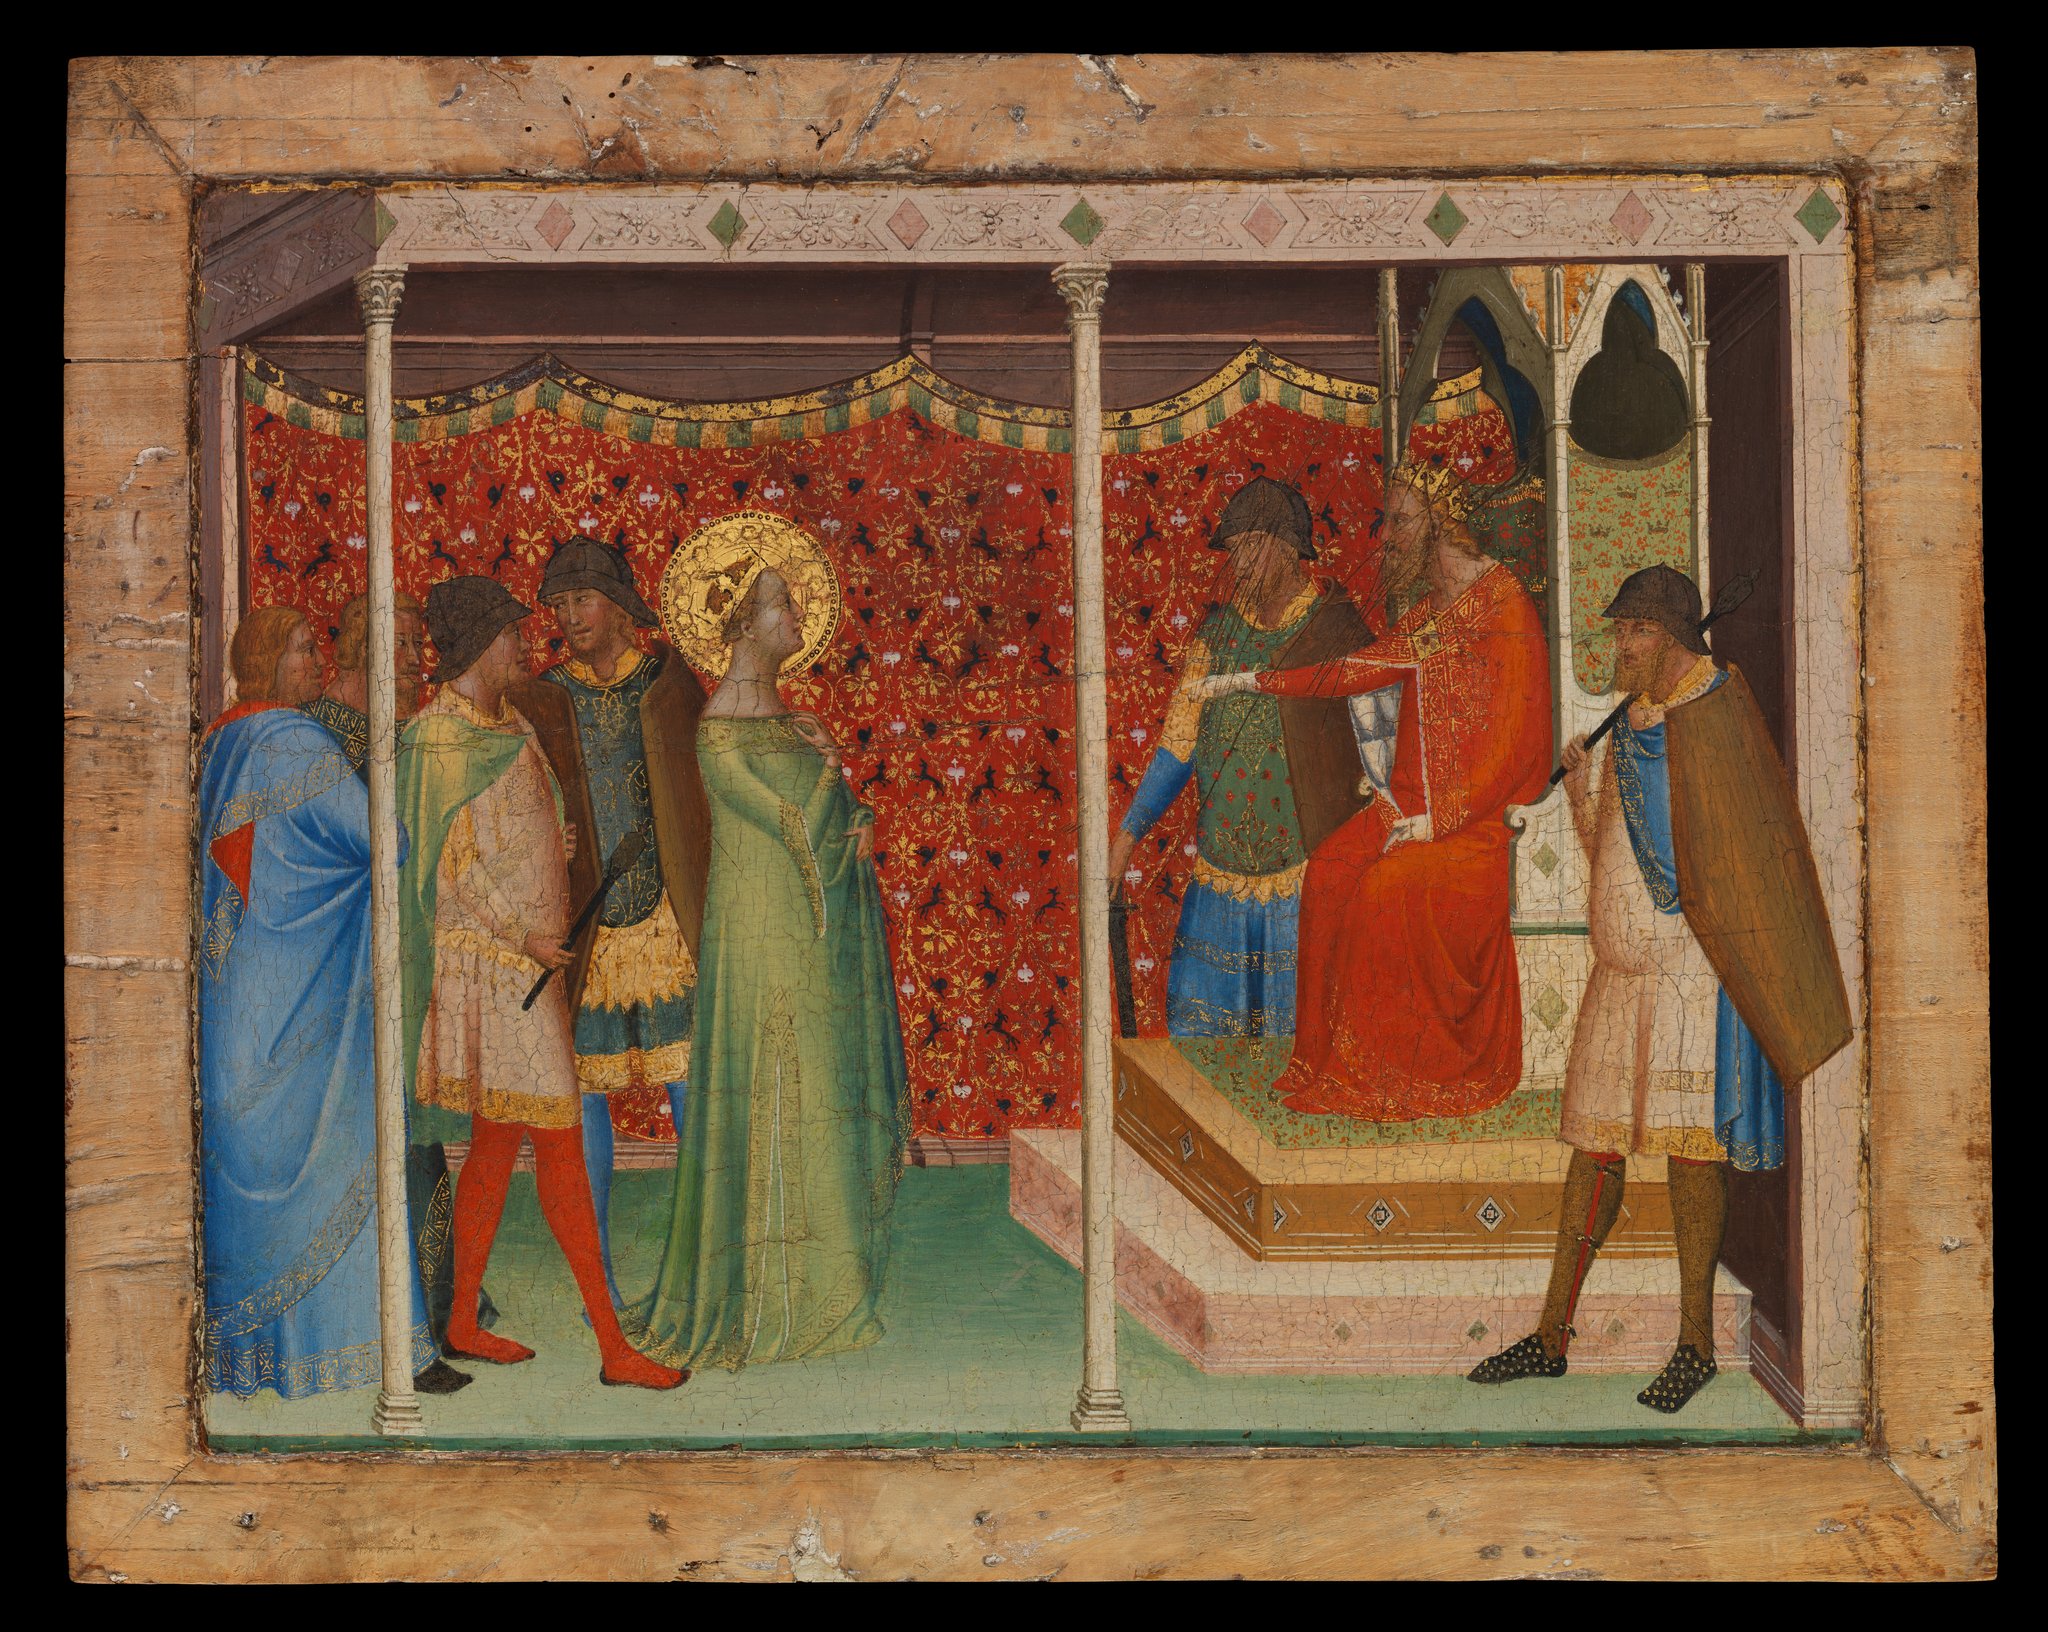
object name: painting, predella panel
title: Saint Reparata before the Emperor Decius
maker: bernardo daddi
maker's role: artist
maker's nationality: italian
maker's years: 1290-1348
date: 1338-1340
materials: paint, wood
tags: interiors,men,women,saints